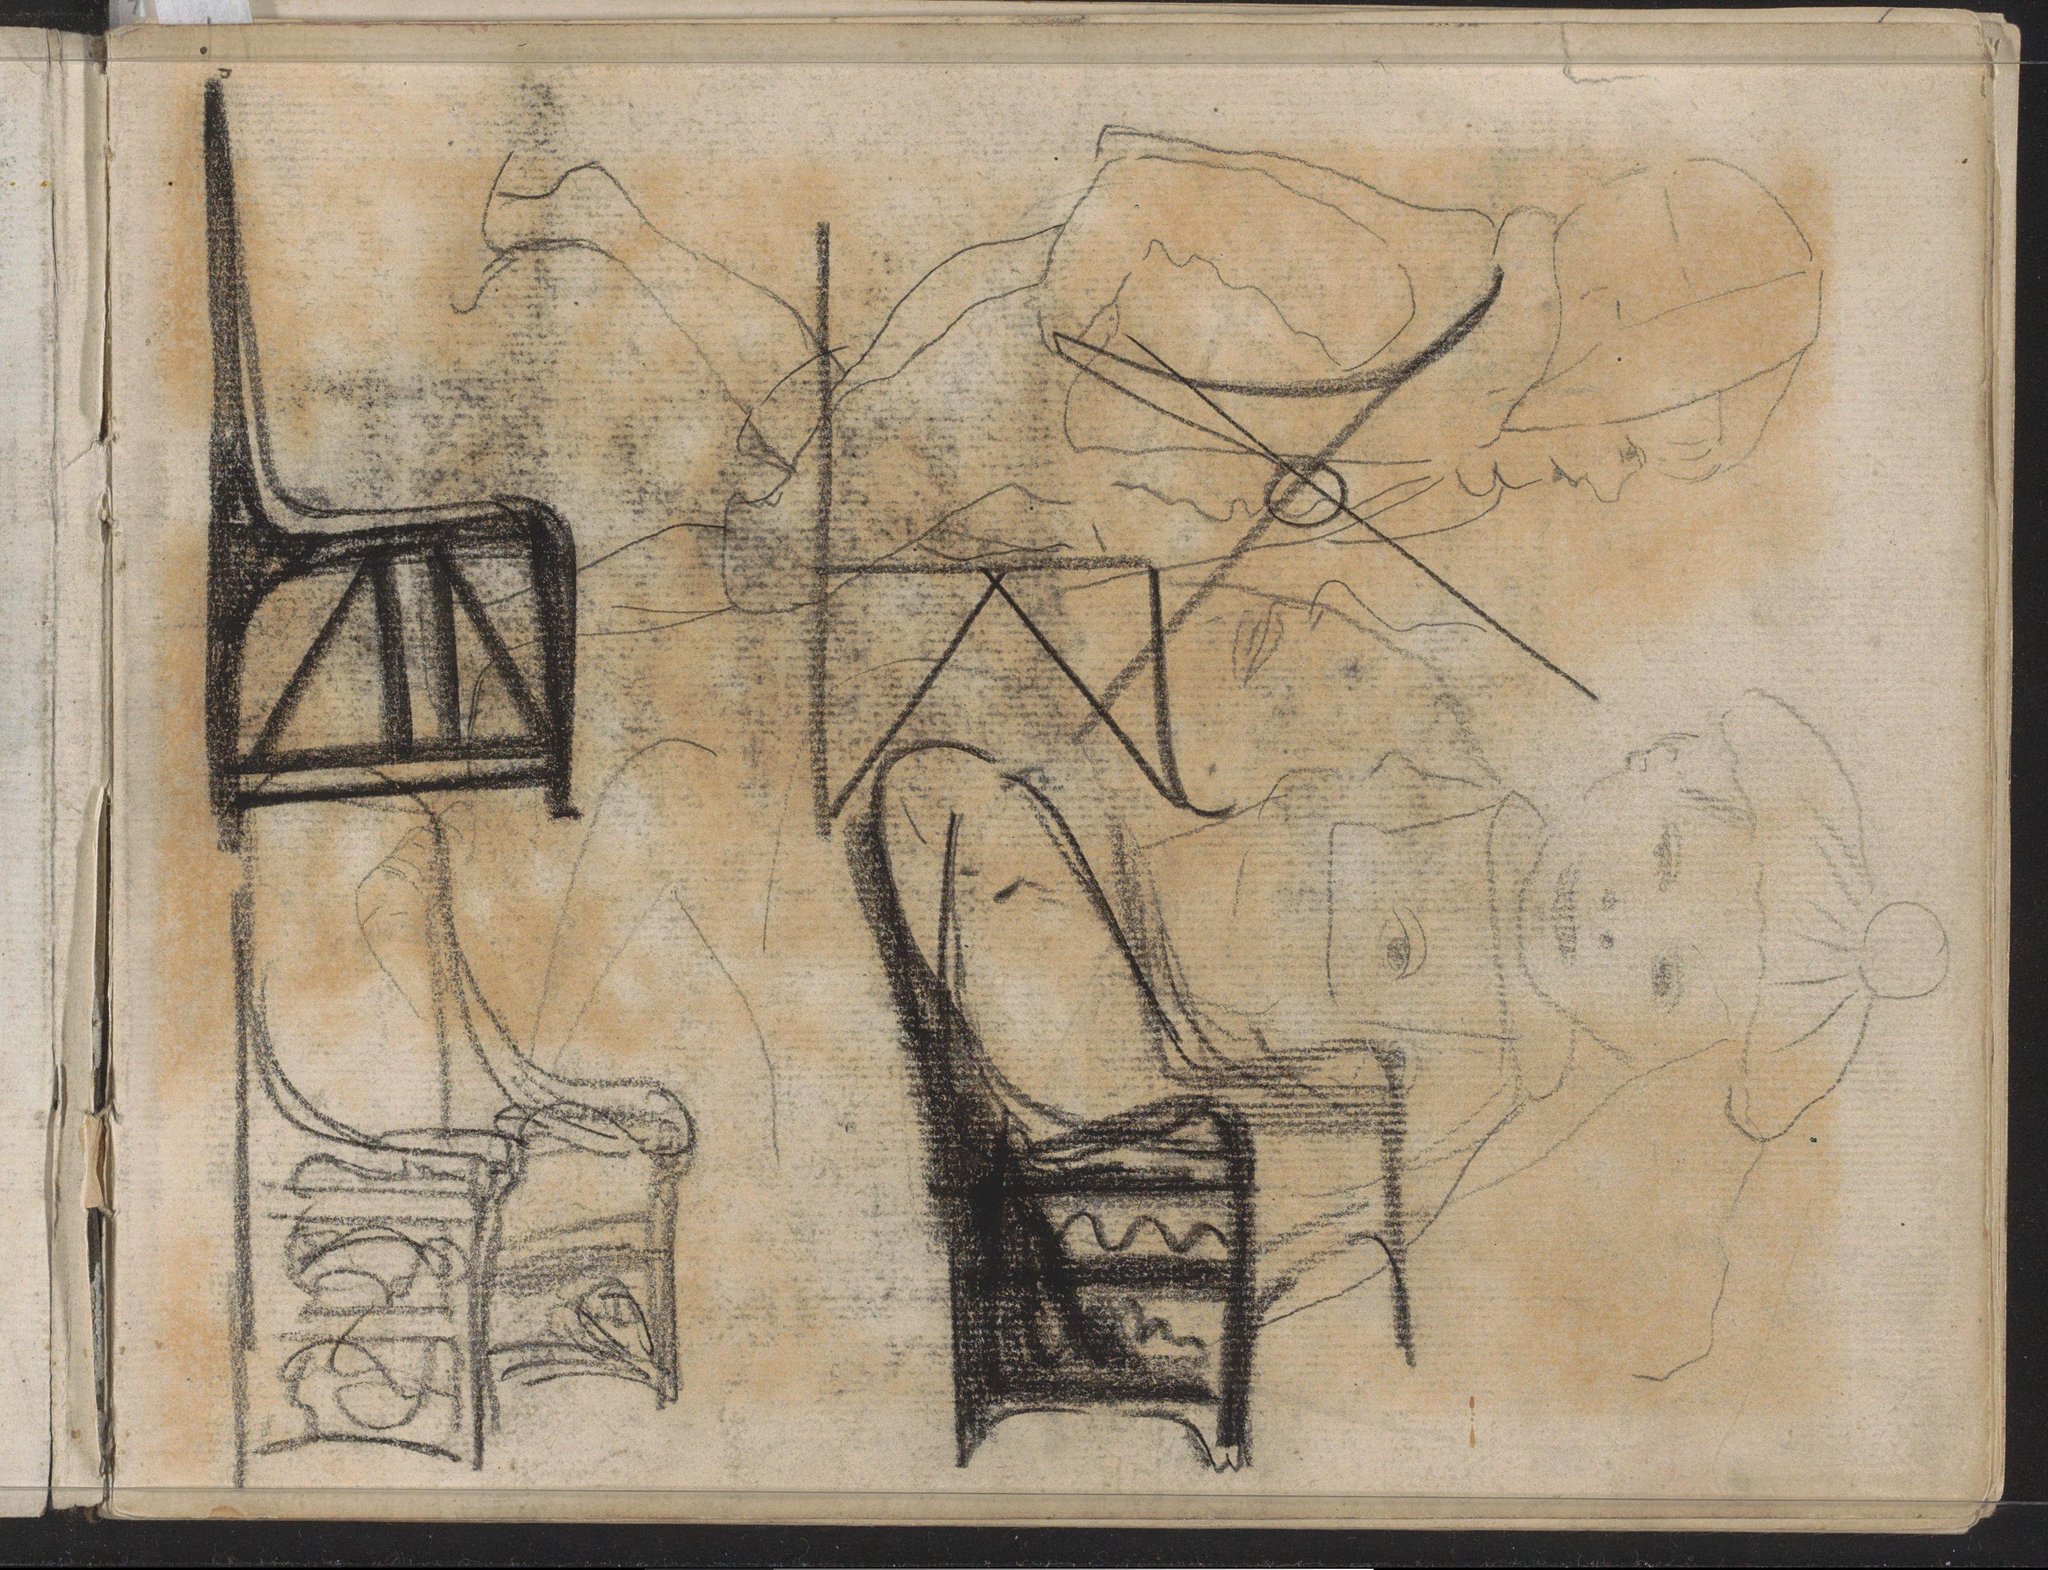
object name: sketchbook leaf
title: Ontwerpen voor stoelen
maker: carel adolph lion cachet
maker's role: draughtsman, print maker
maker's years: 1864-1945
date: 1896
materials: chalk, paper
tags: child, chair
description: Tevens twee figuurstudies van een kind. Blad 1 recto uit een schetsboek met 44 bladen.